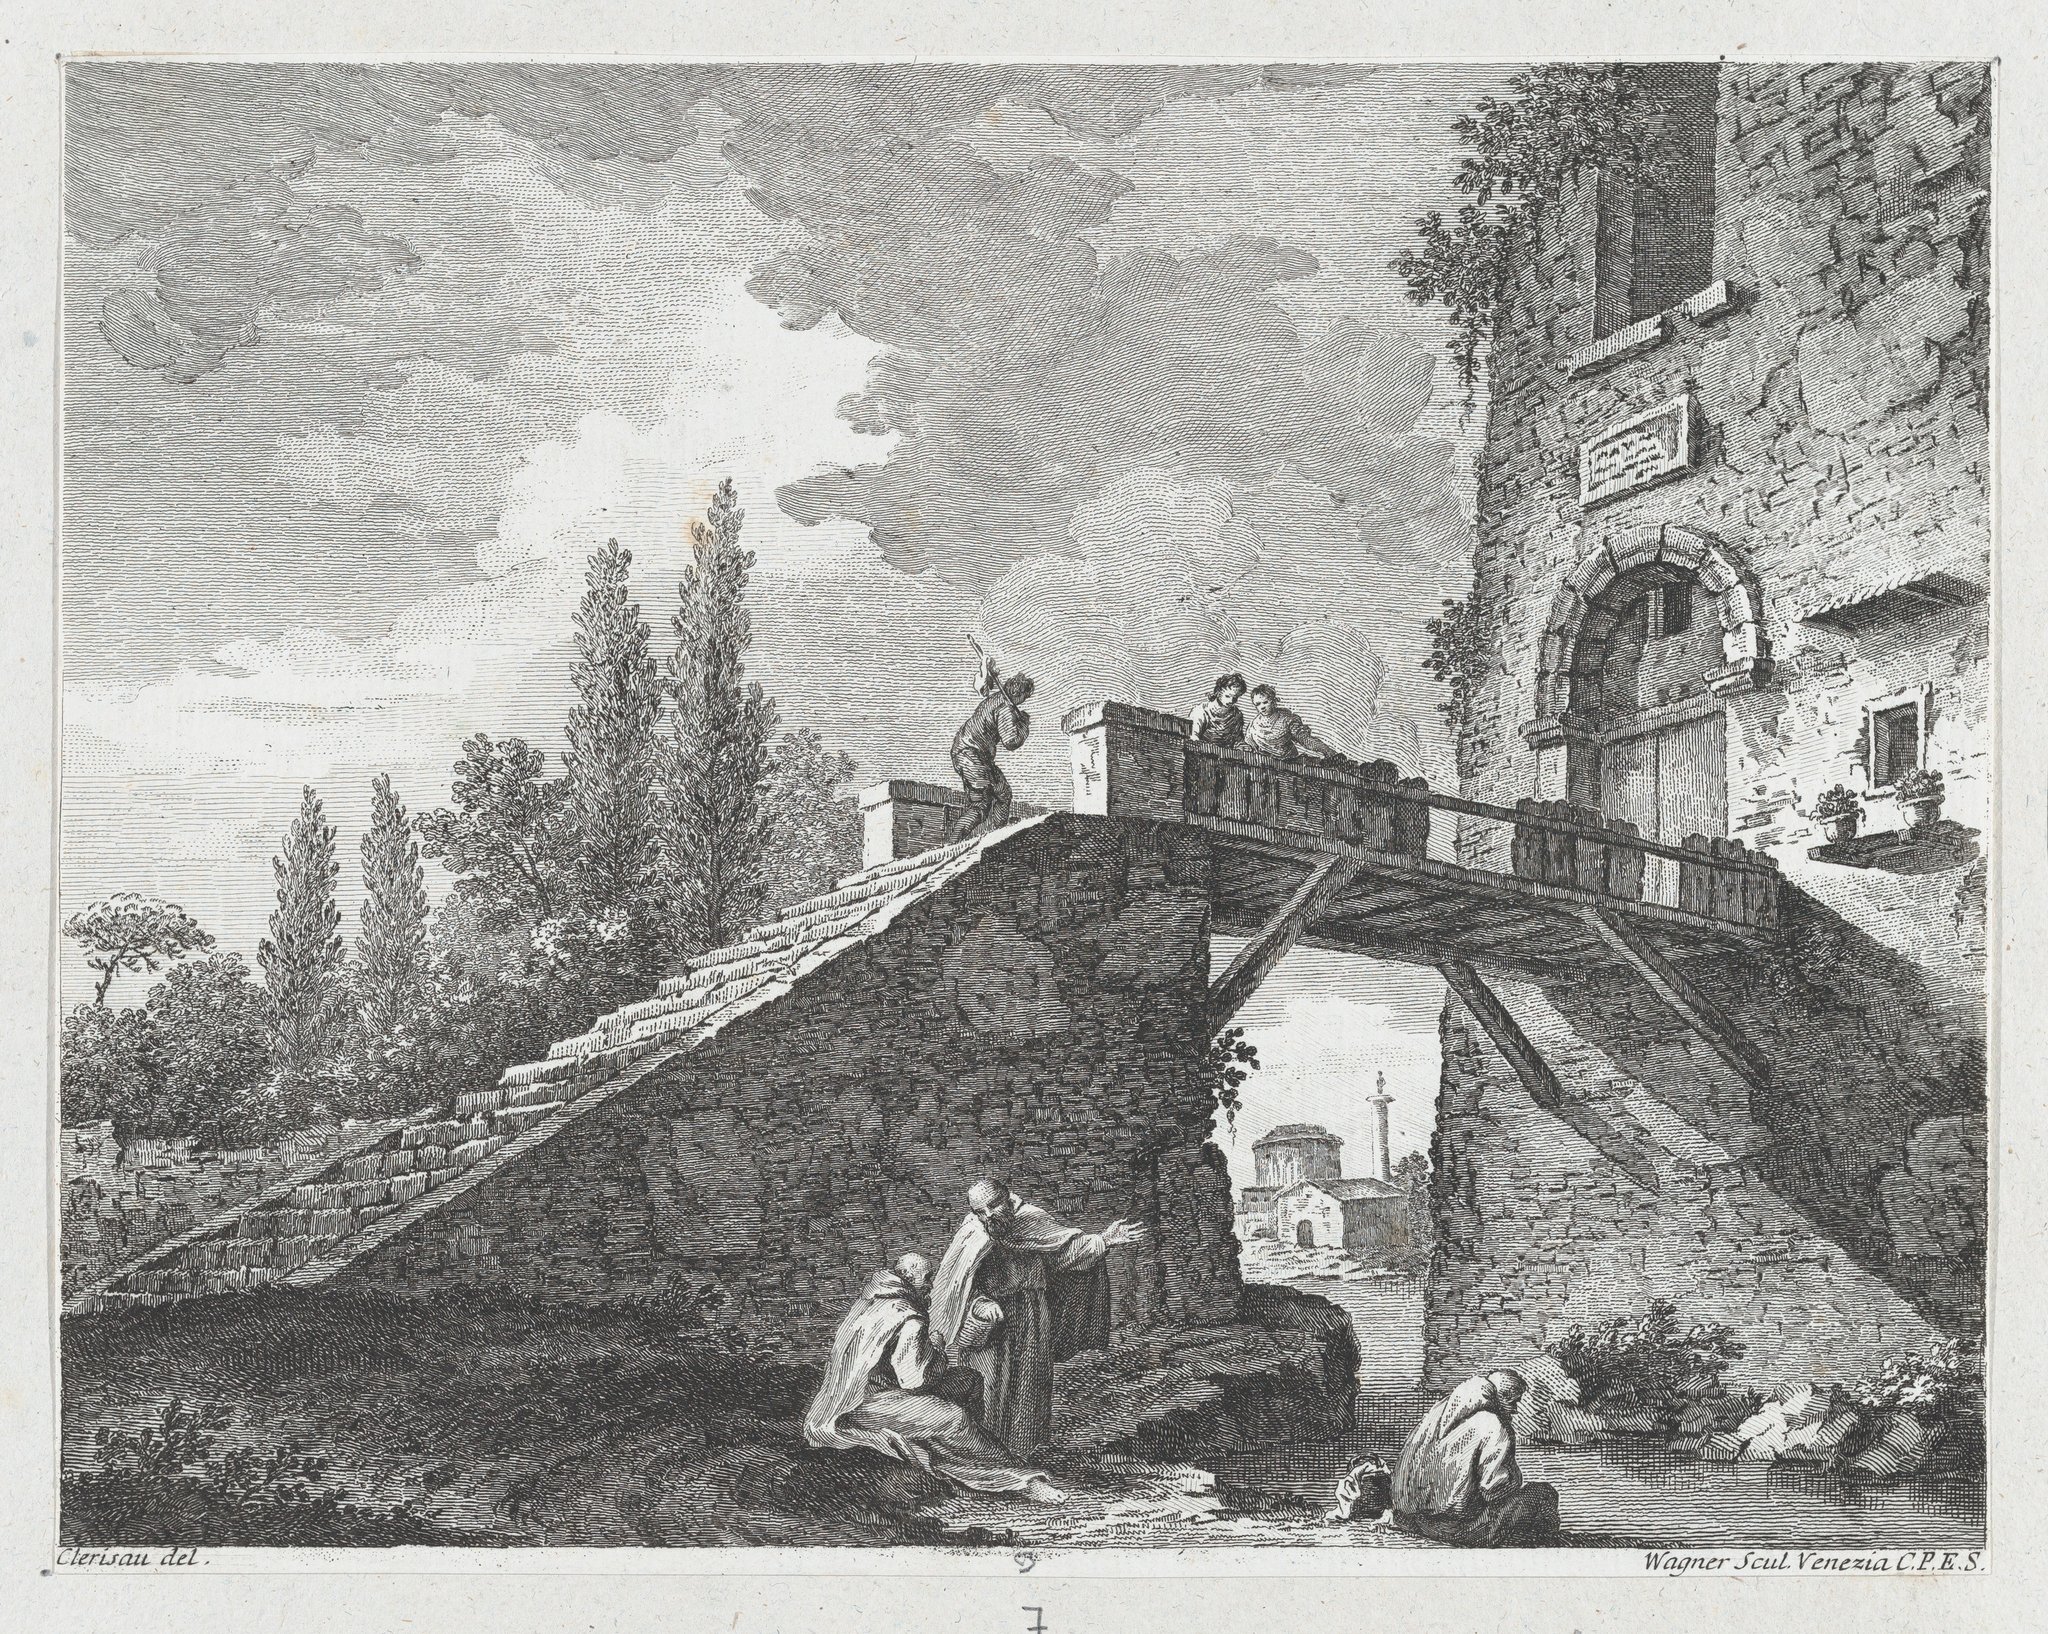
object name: print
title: Landscape with Bridge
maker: joseph wagner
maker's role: artist and publisher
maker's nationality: italian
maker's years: 1706-1780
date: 1750-1770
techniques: etching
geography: venice